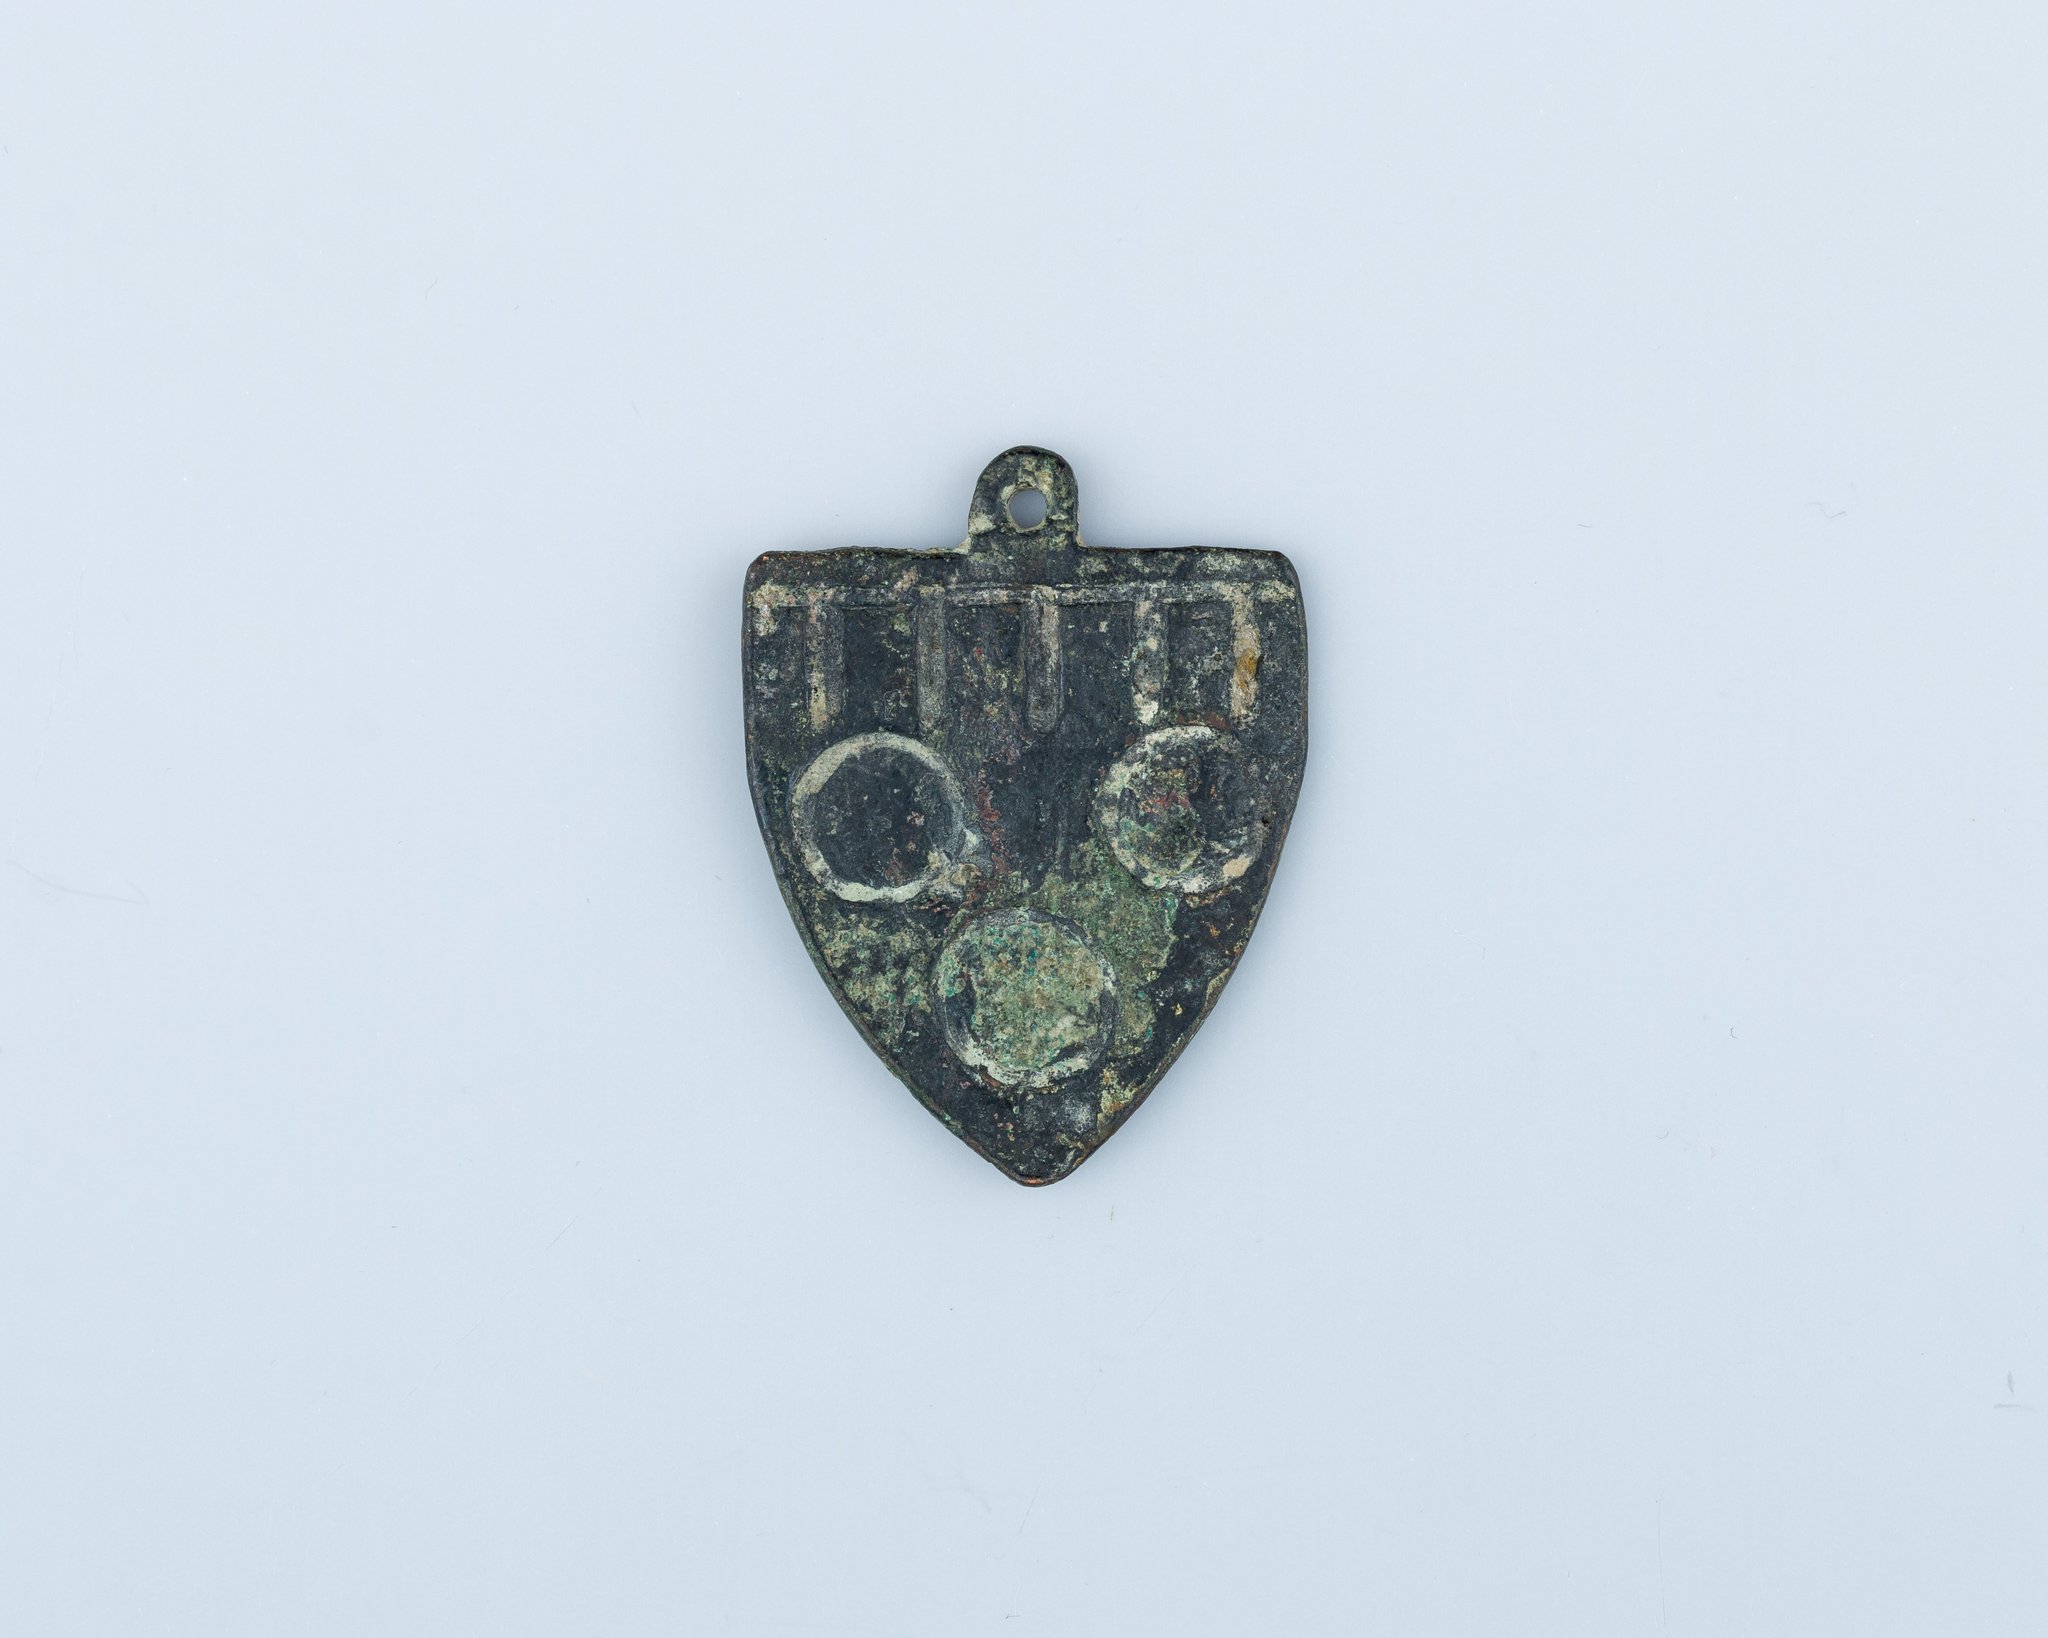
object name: ornament of horse trapping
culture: spanish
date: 1301-1400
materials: bronze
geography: spain